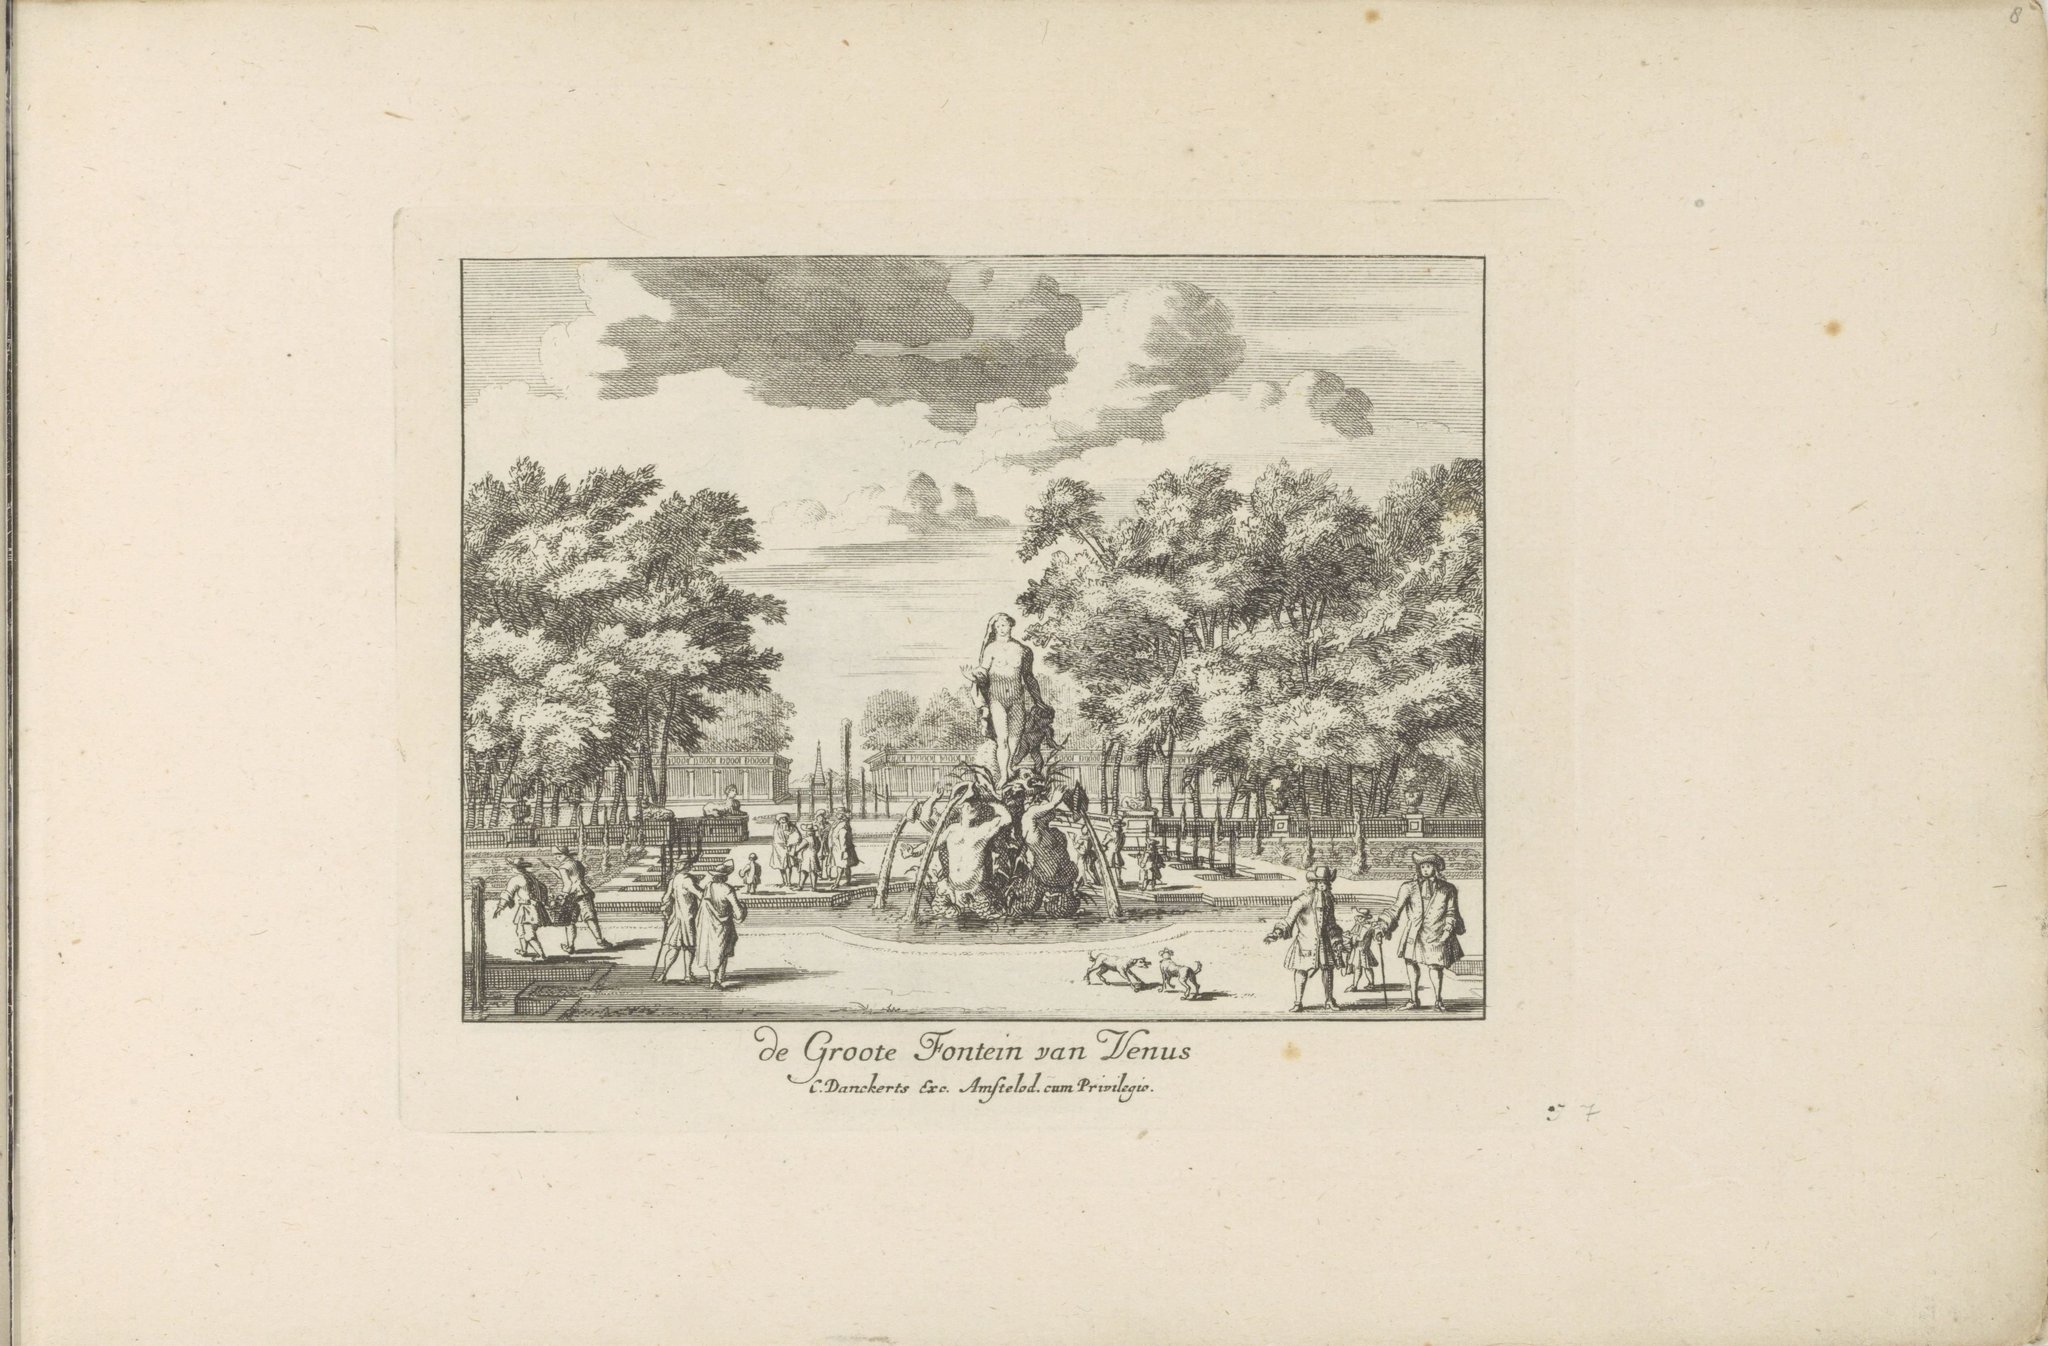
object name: album leaf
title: Nette Afbeeldinge Van de Lust-Tuin, en 't Hof-Gebouw, Van zyn Kooninglyke Majesteit van Groot-Brittanje, enz. enz. enz. Geleegen op 't Loo In Gelderland (...) / Representation au Naturel de Loo En Gueldre. Maison de plaisance de sa Majesté Britannique (...)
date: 1696-1718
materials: paper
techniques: etching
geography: amsterdam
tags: garden fountain, french or architectonic garden; formal garden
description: Gezicht op de Venusfontein in de tuin van Paleis Het Loo. Prent maakt deel uit van een album.